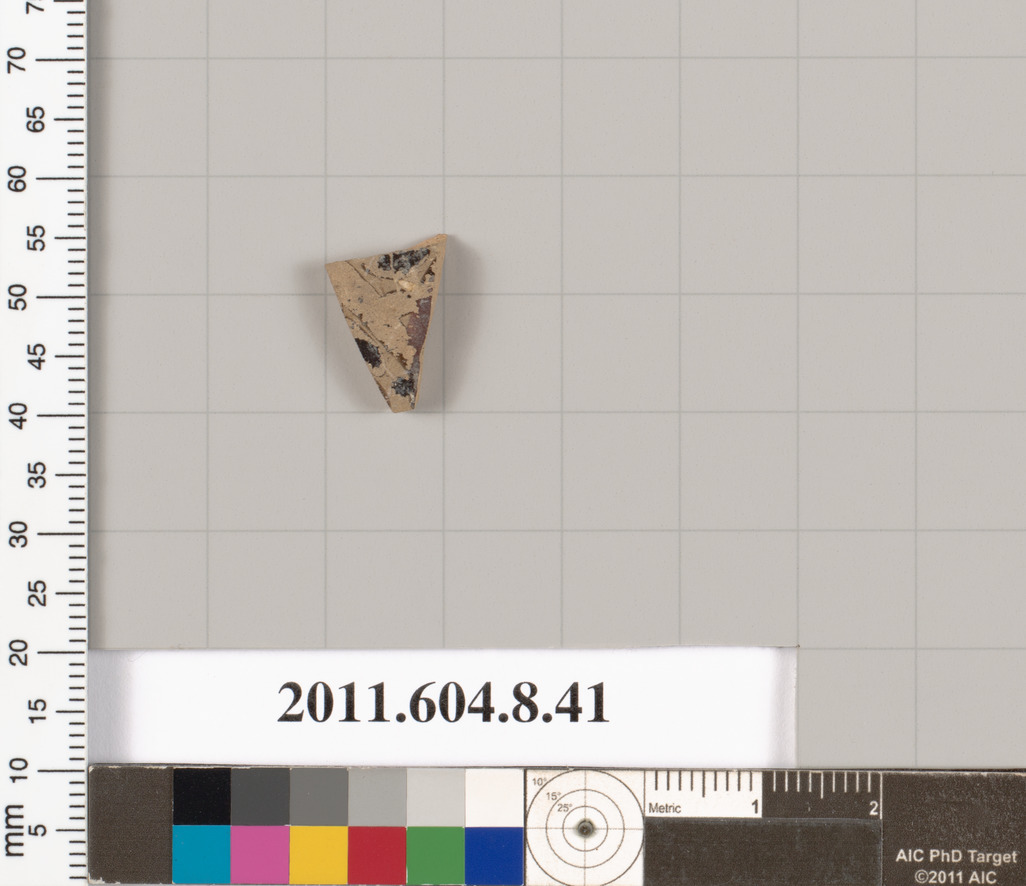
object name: undetermined closed shape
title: Terracotta fragment of a closed shape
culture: greek, corinthian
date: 600-501 BCE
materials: terracotta